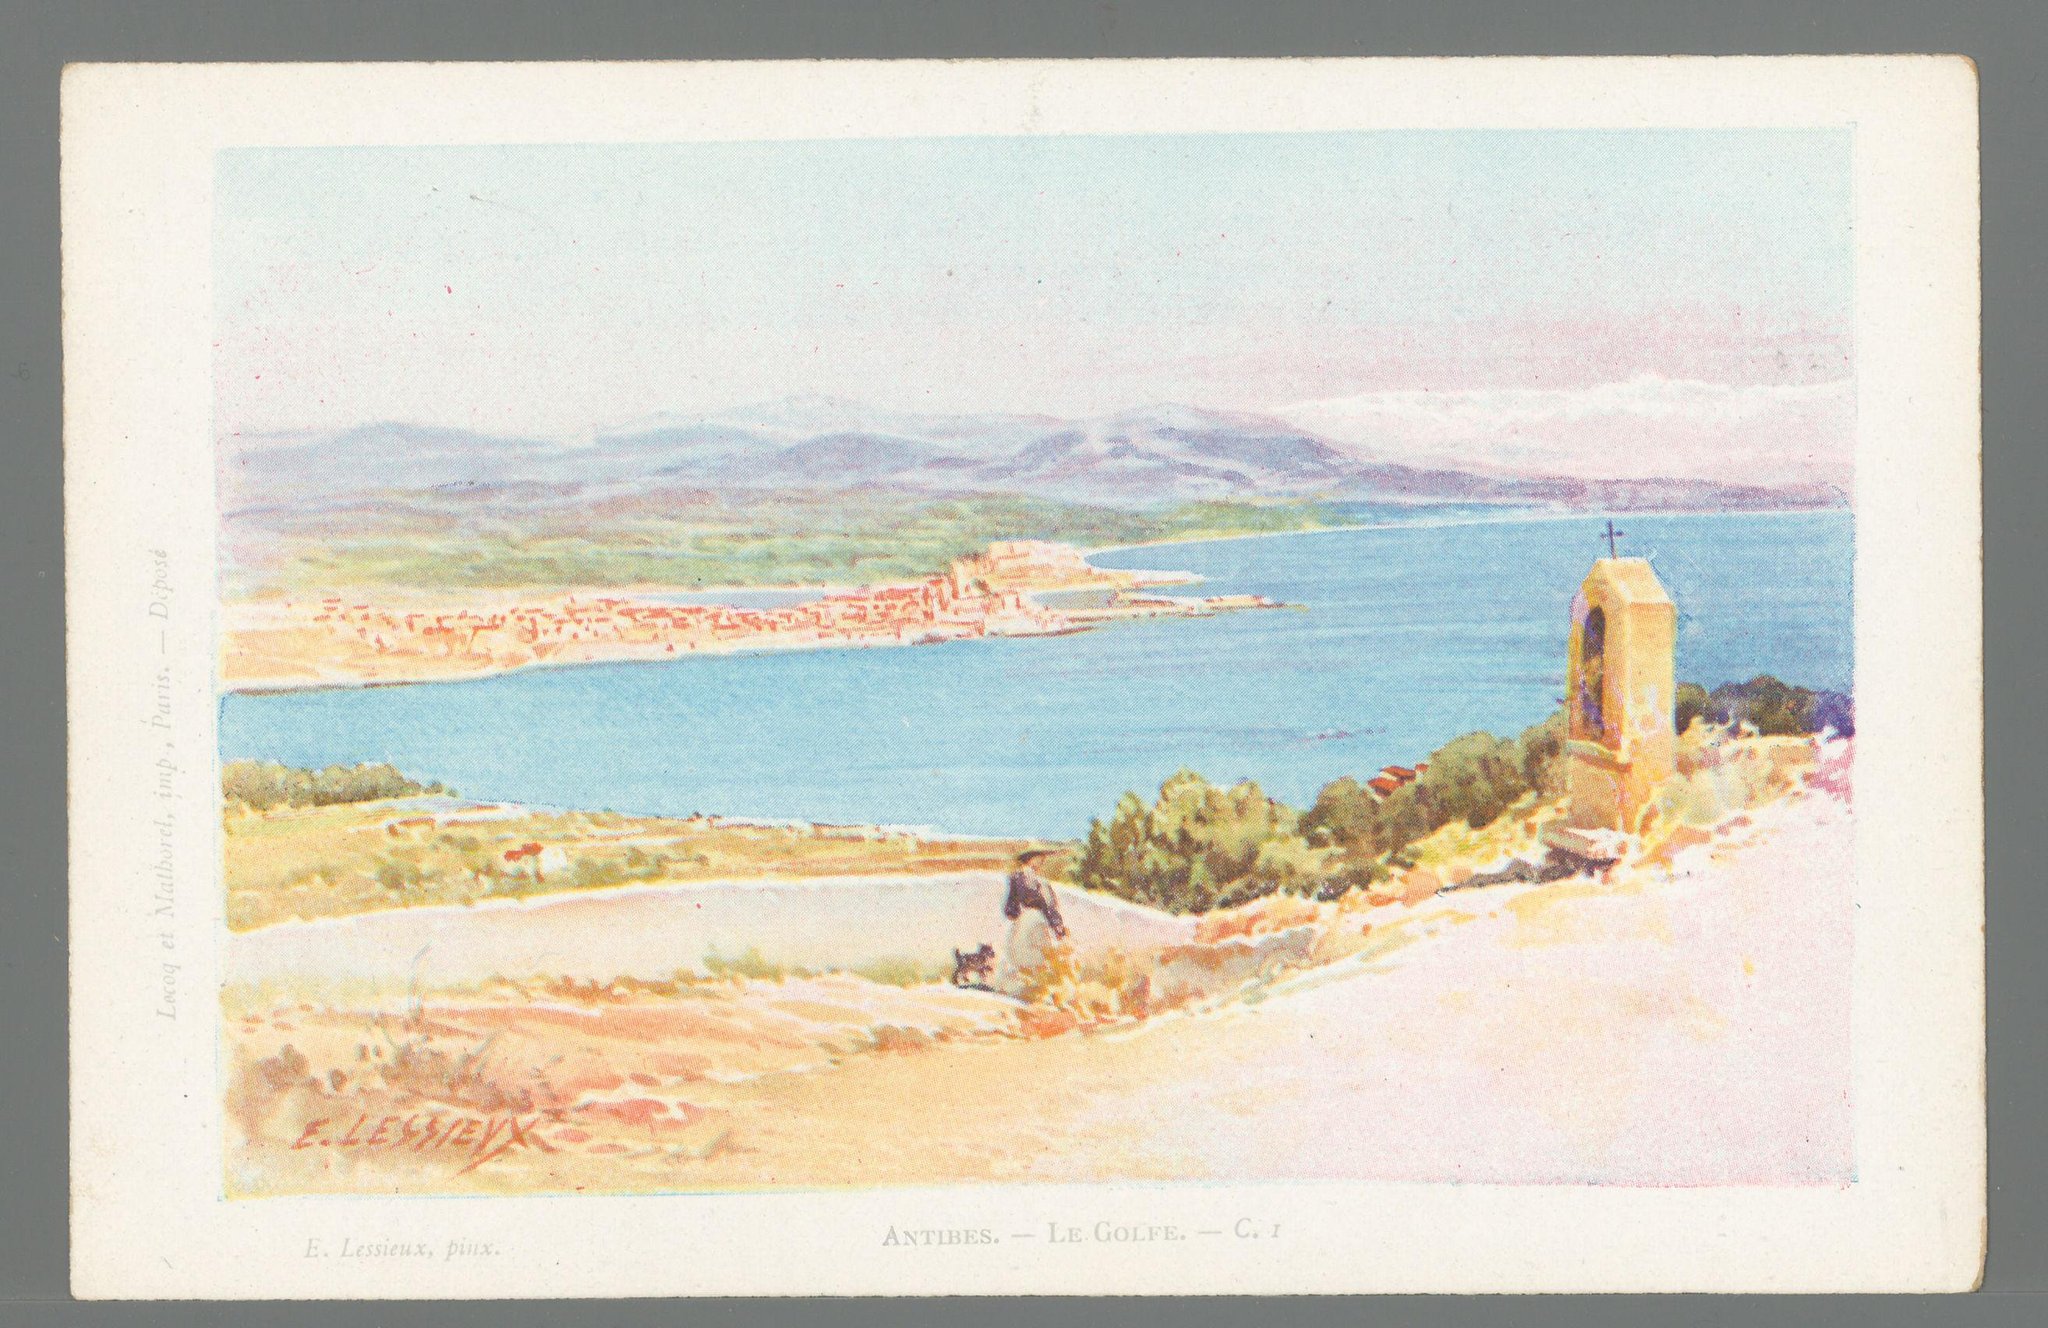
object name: reproduction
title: Antibes. Le Golfe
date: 1892-1904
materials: cardboard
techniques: writing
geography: paris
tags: landscapes with waters, waterscapes, seascapes (in the temperate zone), church (exterior) - qq - small church, chapel, landscapes (+ landscape with figures, staffage)